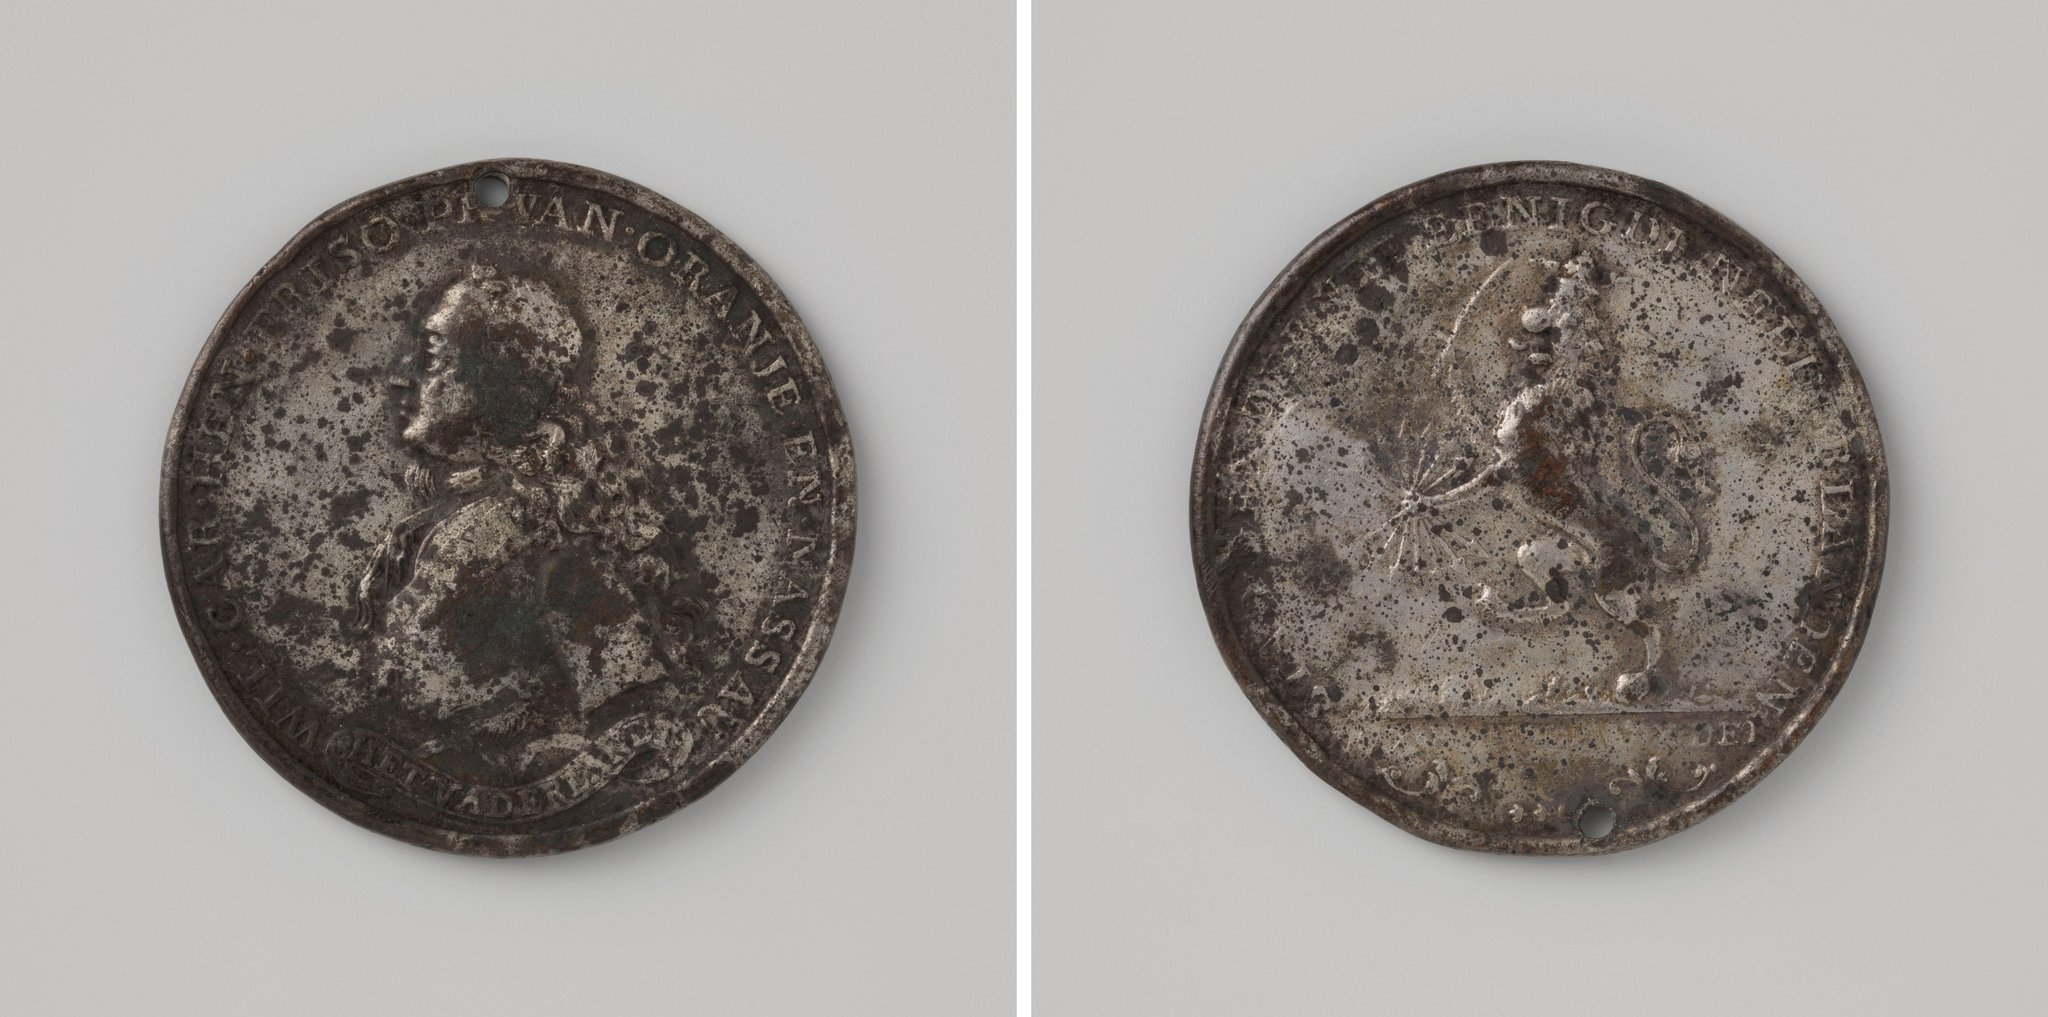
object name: history medal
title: Verheffing van Willem Karel Hendrik Friso tot stadhouder, 1747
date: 1747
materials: copper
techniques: casting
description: Verzilverd koperen penning, op de voorzijde het borstbeeld van Willem boven een banderol met opschrtift HET VADERLANDT, met omschrift, op de keerzijde een gekroonde leeuw met zwaard en pijlenbundel, met omschrift en afsnedetekst, met doorboring